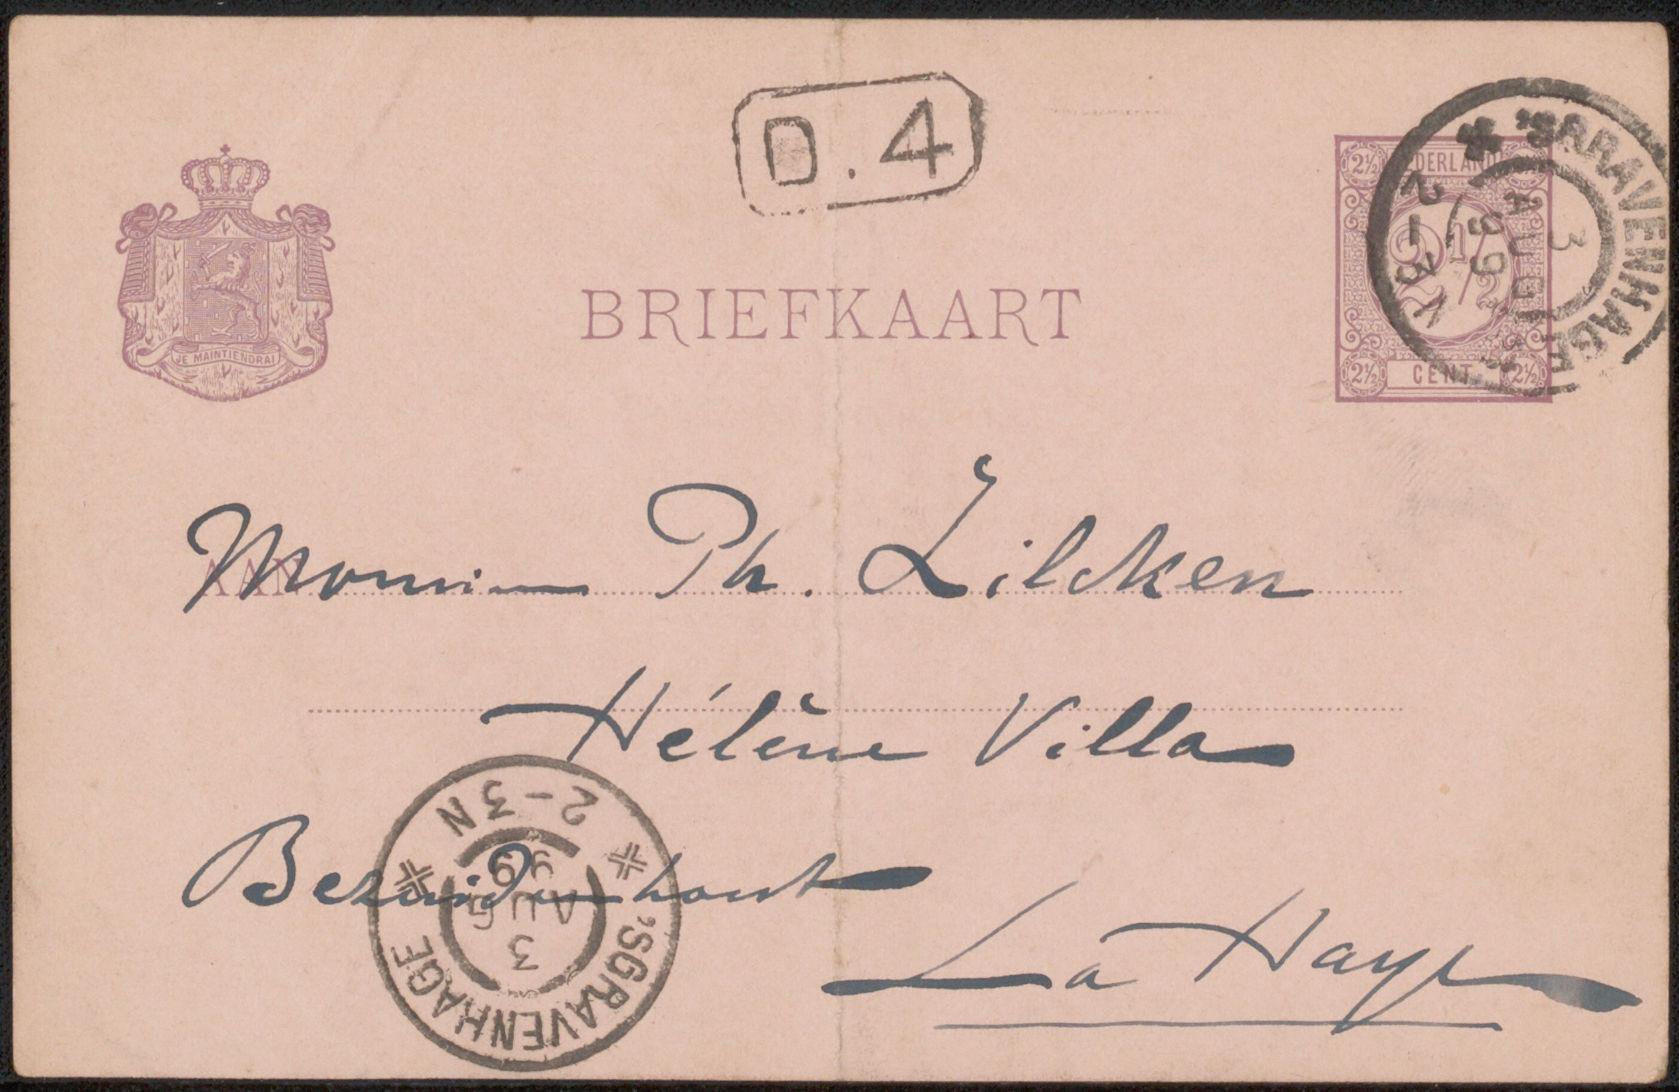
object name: letter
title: Brief aan Philip Zilcken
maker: carel nicolaas storm van s-gravesande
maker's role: draughtsman, print maker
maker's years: 1841-1924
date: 1899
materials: cardboard, ink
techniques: pen, writing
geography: the hague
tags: painter, draughtsman, philip zilcken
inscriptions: collector's mark: ‘RPK’